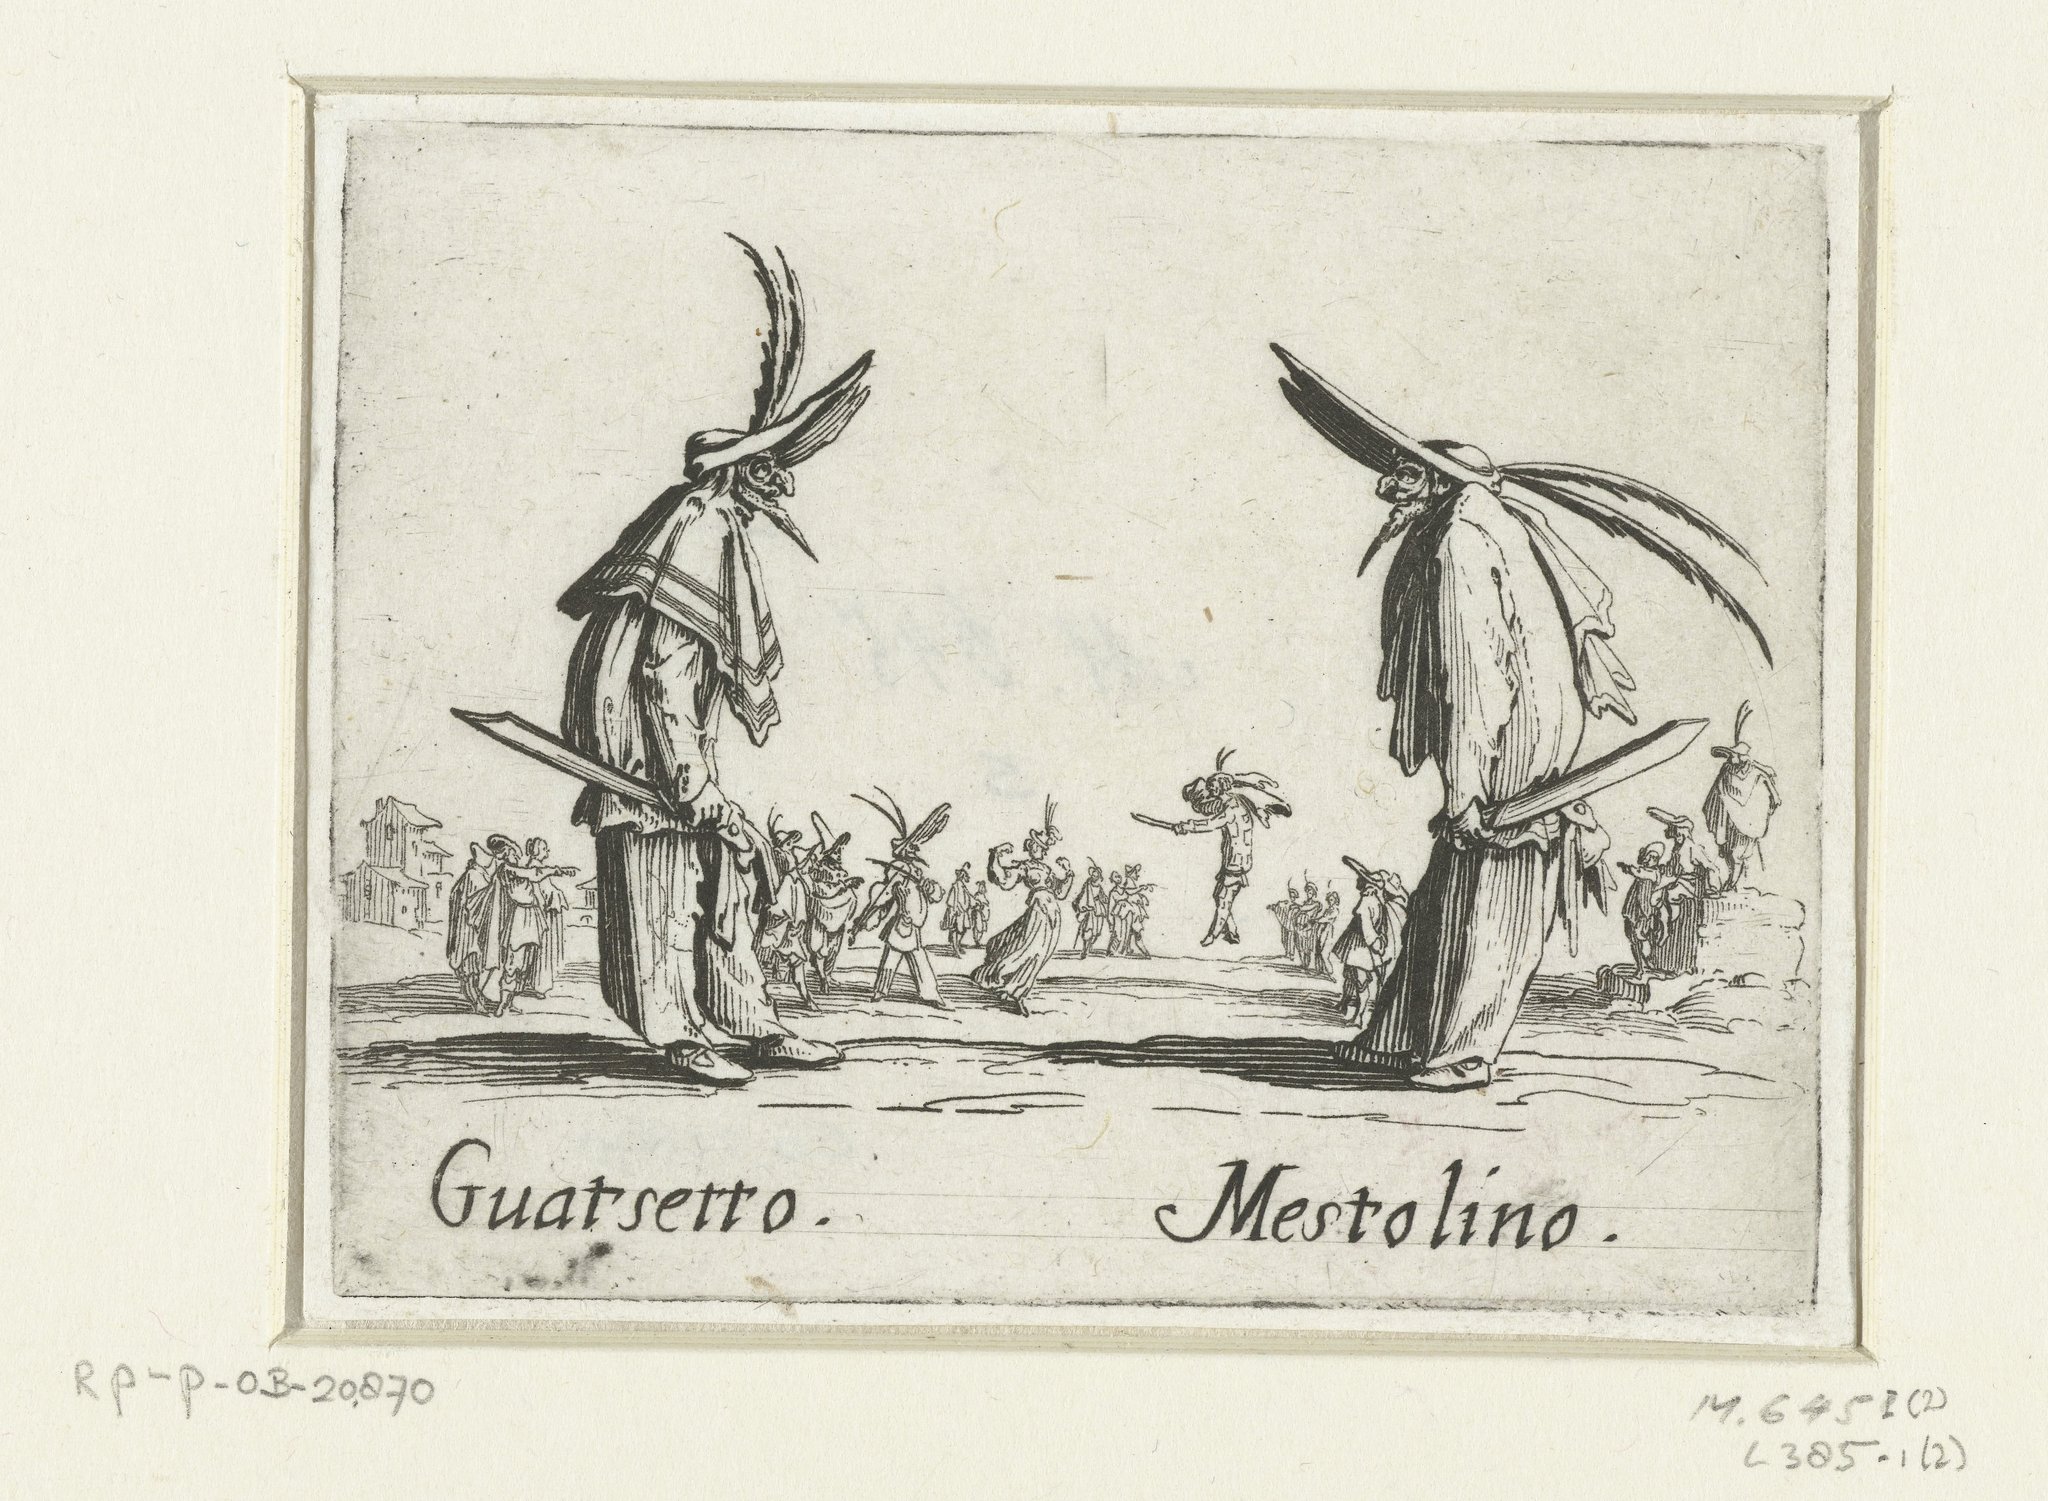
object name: print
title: Dansen van Sfessania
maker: jacques callot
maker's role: draughtsman, print maker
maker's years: 1592-1635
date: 1621-1622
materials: paper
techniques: etching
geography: nancy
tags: types in 'commedia dell'arte'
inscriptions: collector's mark: Lugt 240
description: Twee artiesten met gevederde hoofddeksels op en zwaarden in de hand staan tegenover elkaar. Onder de figuren staan hun namen genoteerd. Deze prent is onderdeel van een serie van 23 prenten (24 incl. titelprent) met telkens op de voorgrond twee straatartiesten verkleed als figuren uit de Italiaanse commedia dell'arte, en op de achtergrond toeschouwers die in de buitenlucht een (dans)voorstelling van straatartiesten gadeslaan.